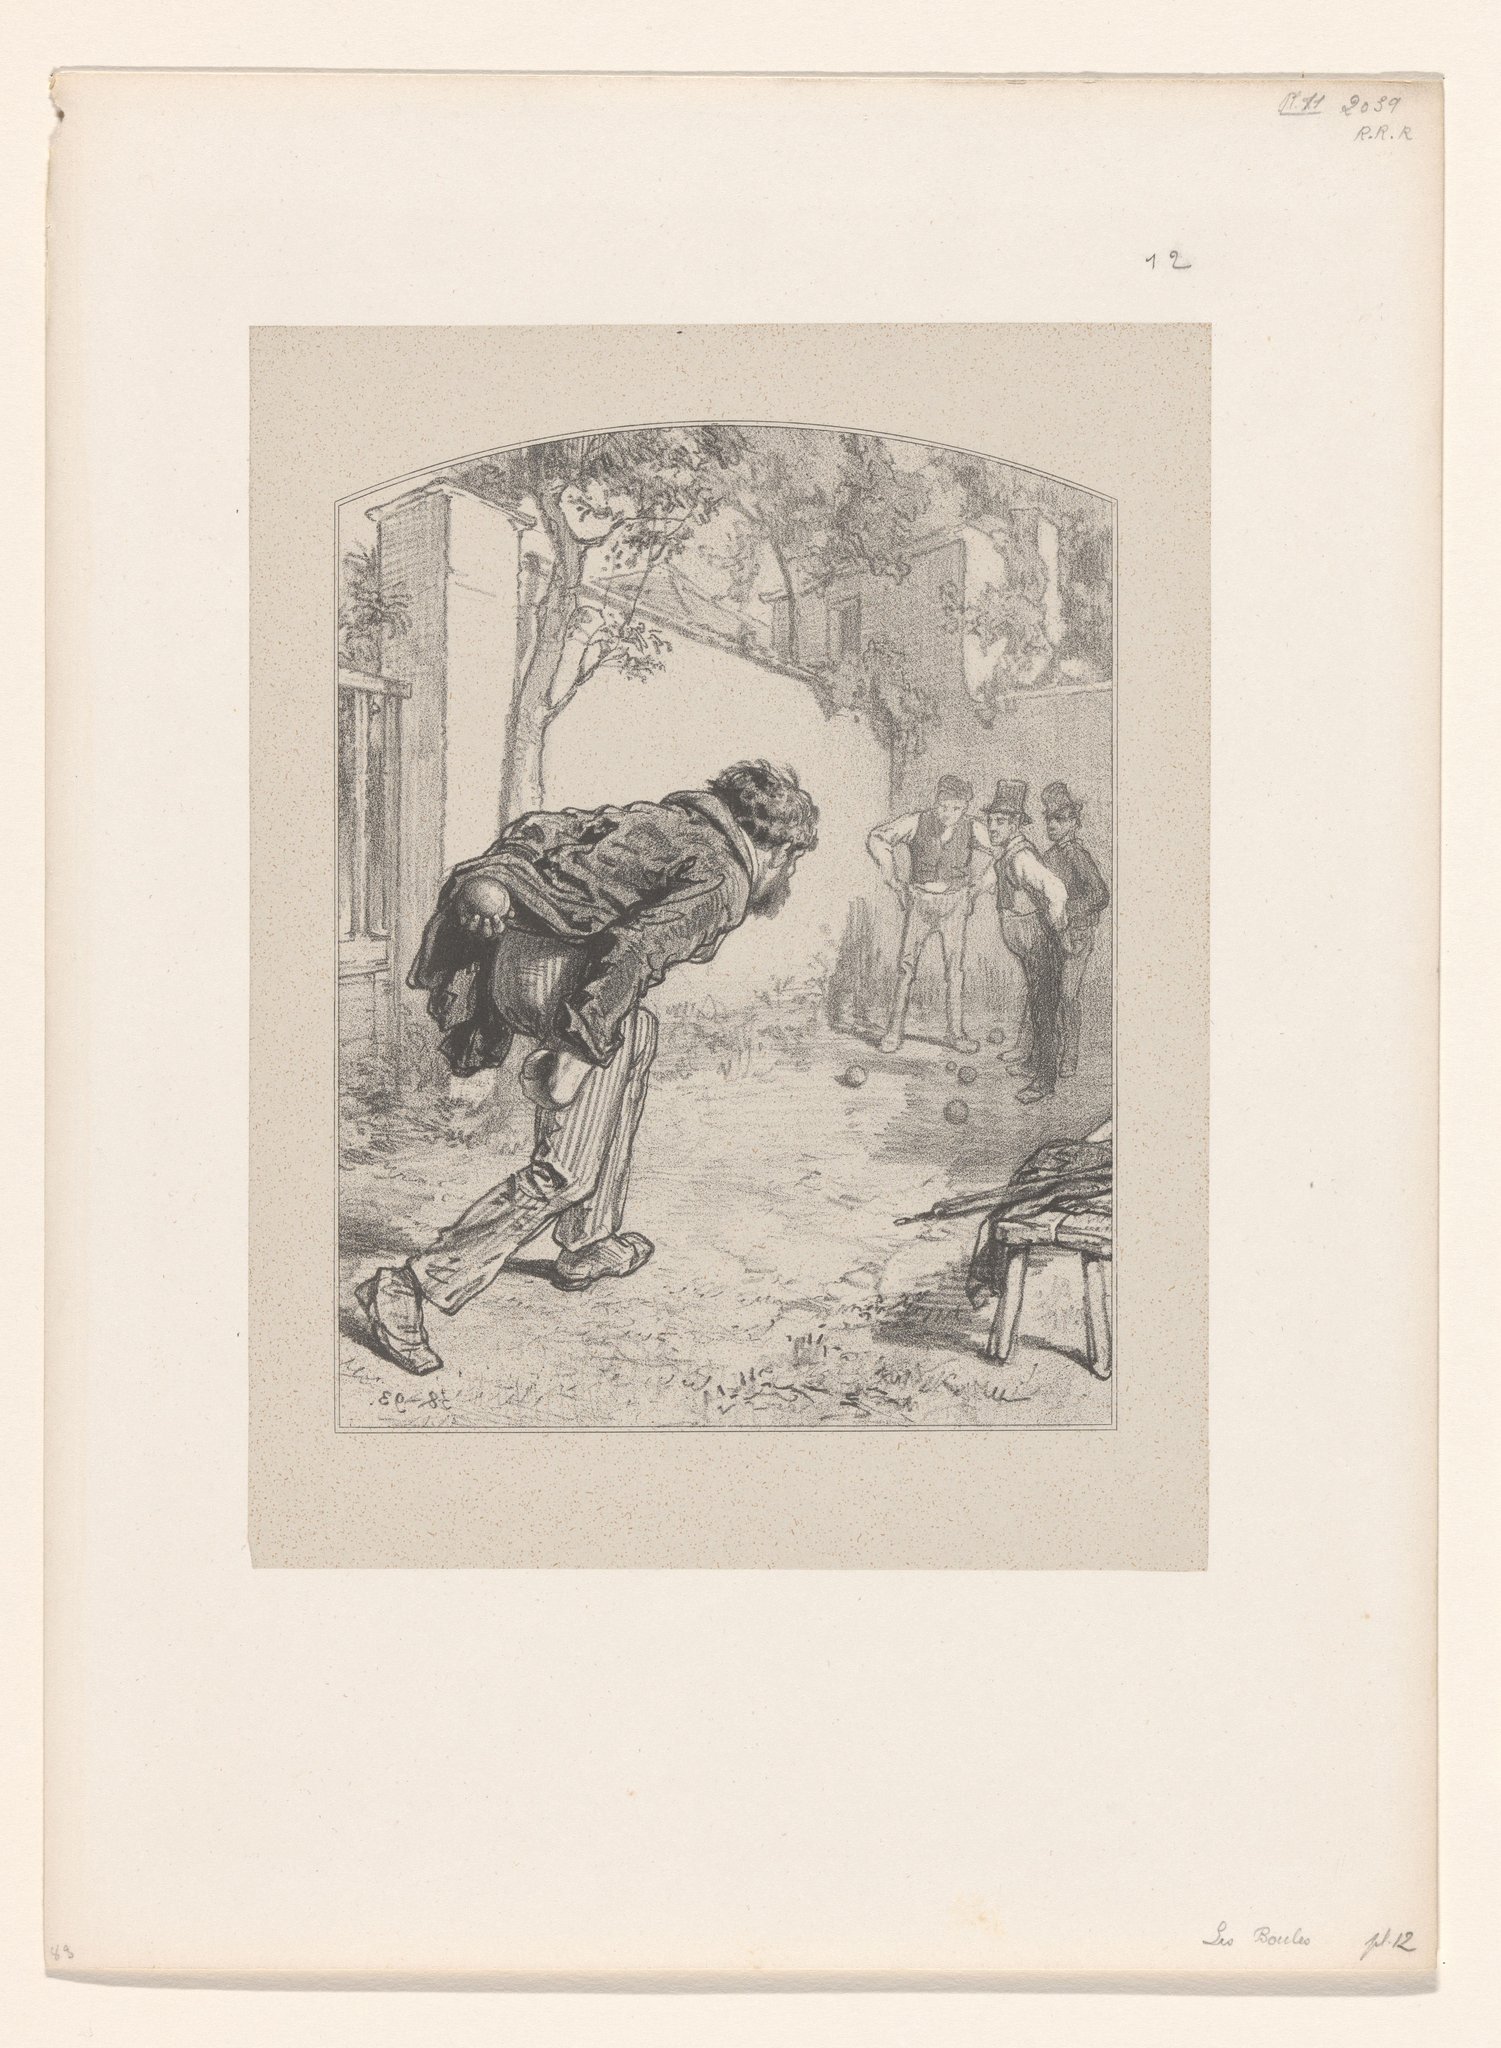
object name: cartoon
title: Les Toquades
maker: paul gavarni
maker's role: draughtsman, print maker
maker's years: 1804-1866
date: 1858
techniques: printmaking, lithograph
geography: paris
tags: 'jeu de boules'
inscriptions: collector's mark: Lugt 2760, collector's mark: Lugt 2228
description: Een speler maakt aanstalten om zijn bal te gooien in een spelletje jeu des boules of petanque. Elfde plaat in een serie van 20 platen verschenen in 1858 onder de titel 'Les Toquades'.